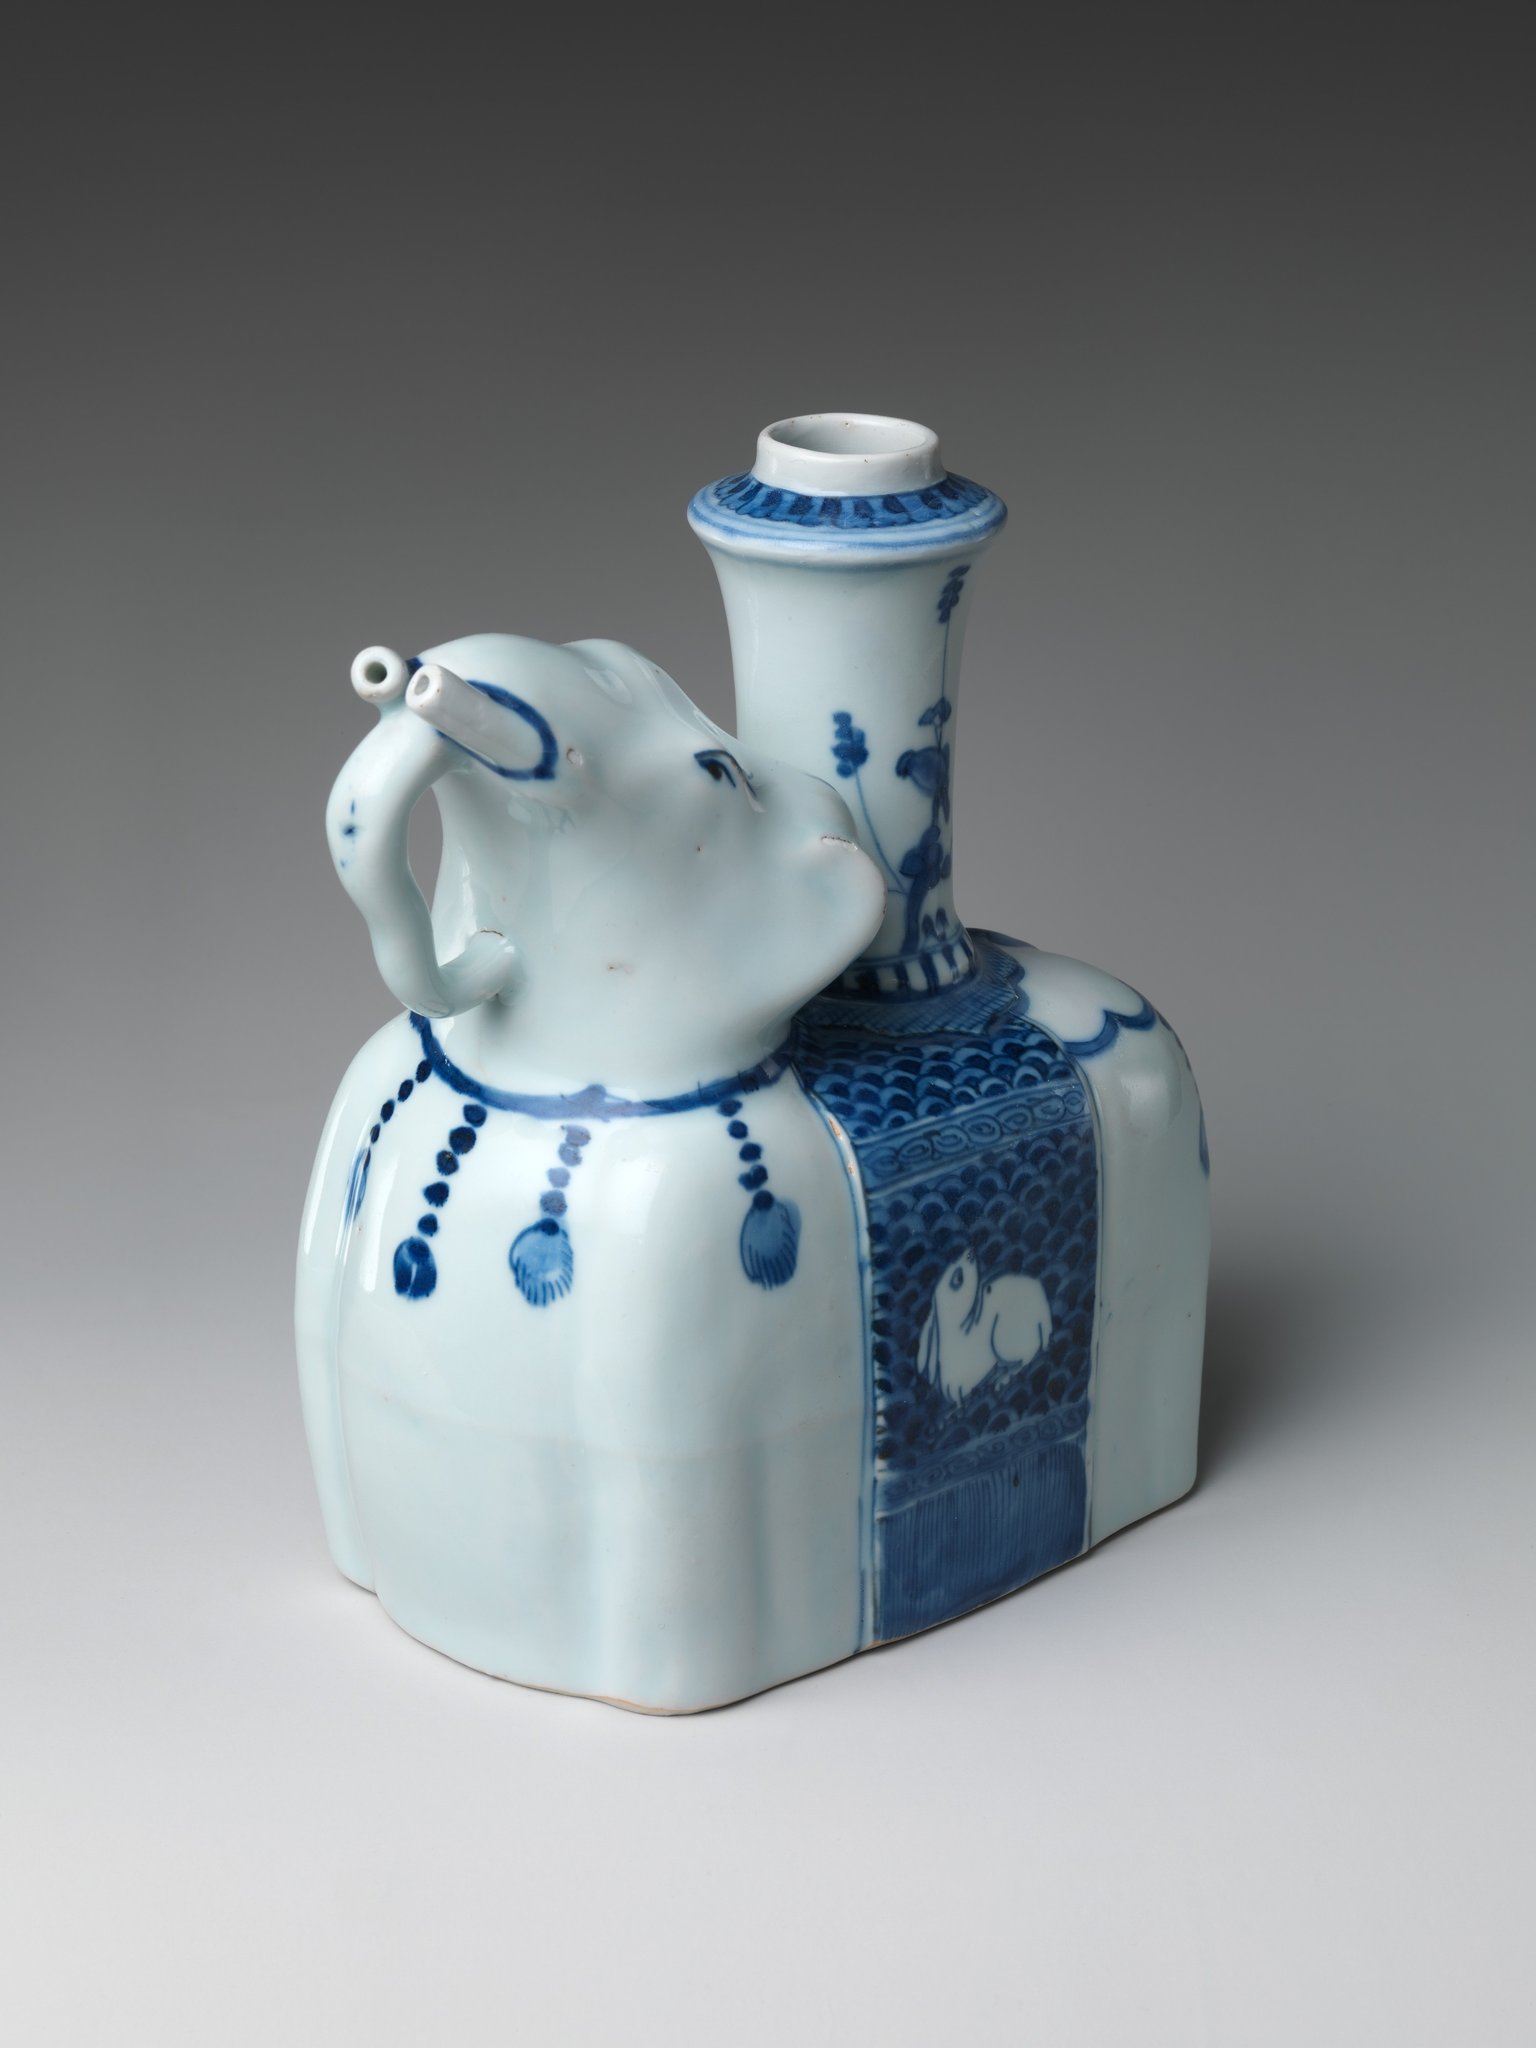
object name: vessel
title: Elephant-Shaped Kendi Drinking Vessel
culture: chinese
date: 1567-1600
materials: porcelain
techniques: painting, underglaze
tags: elephants